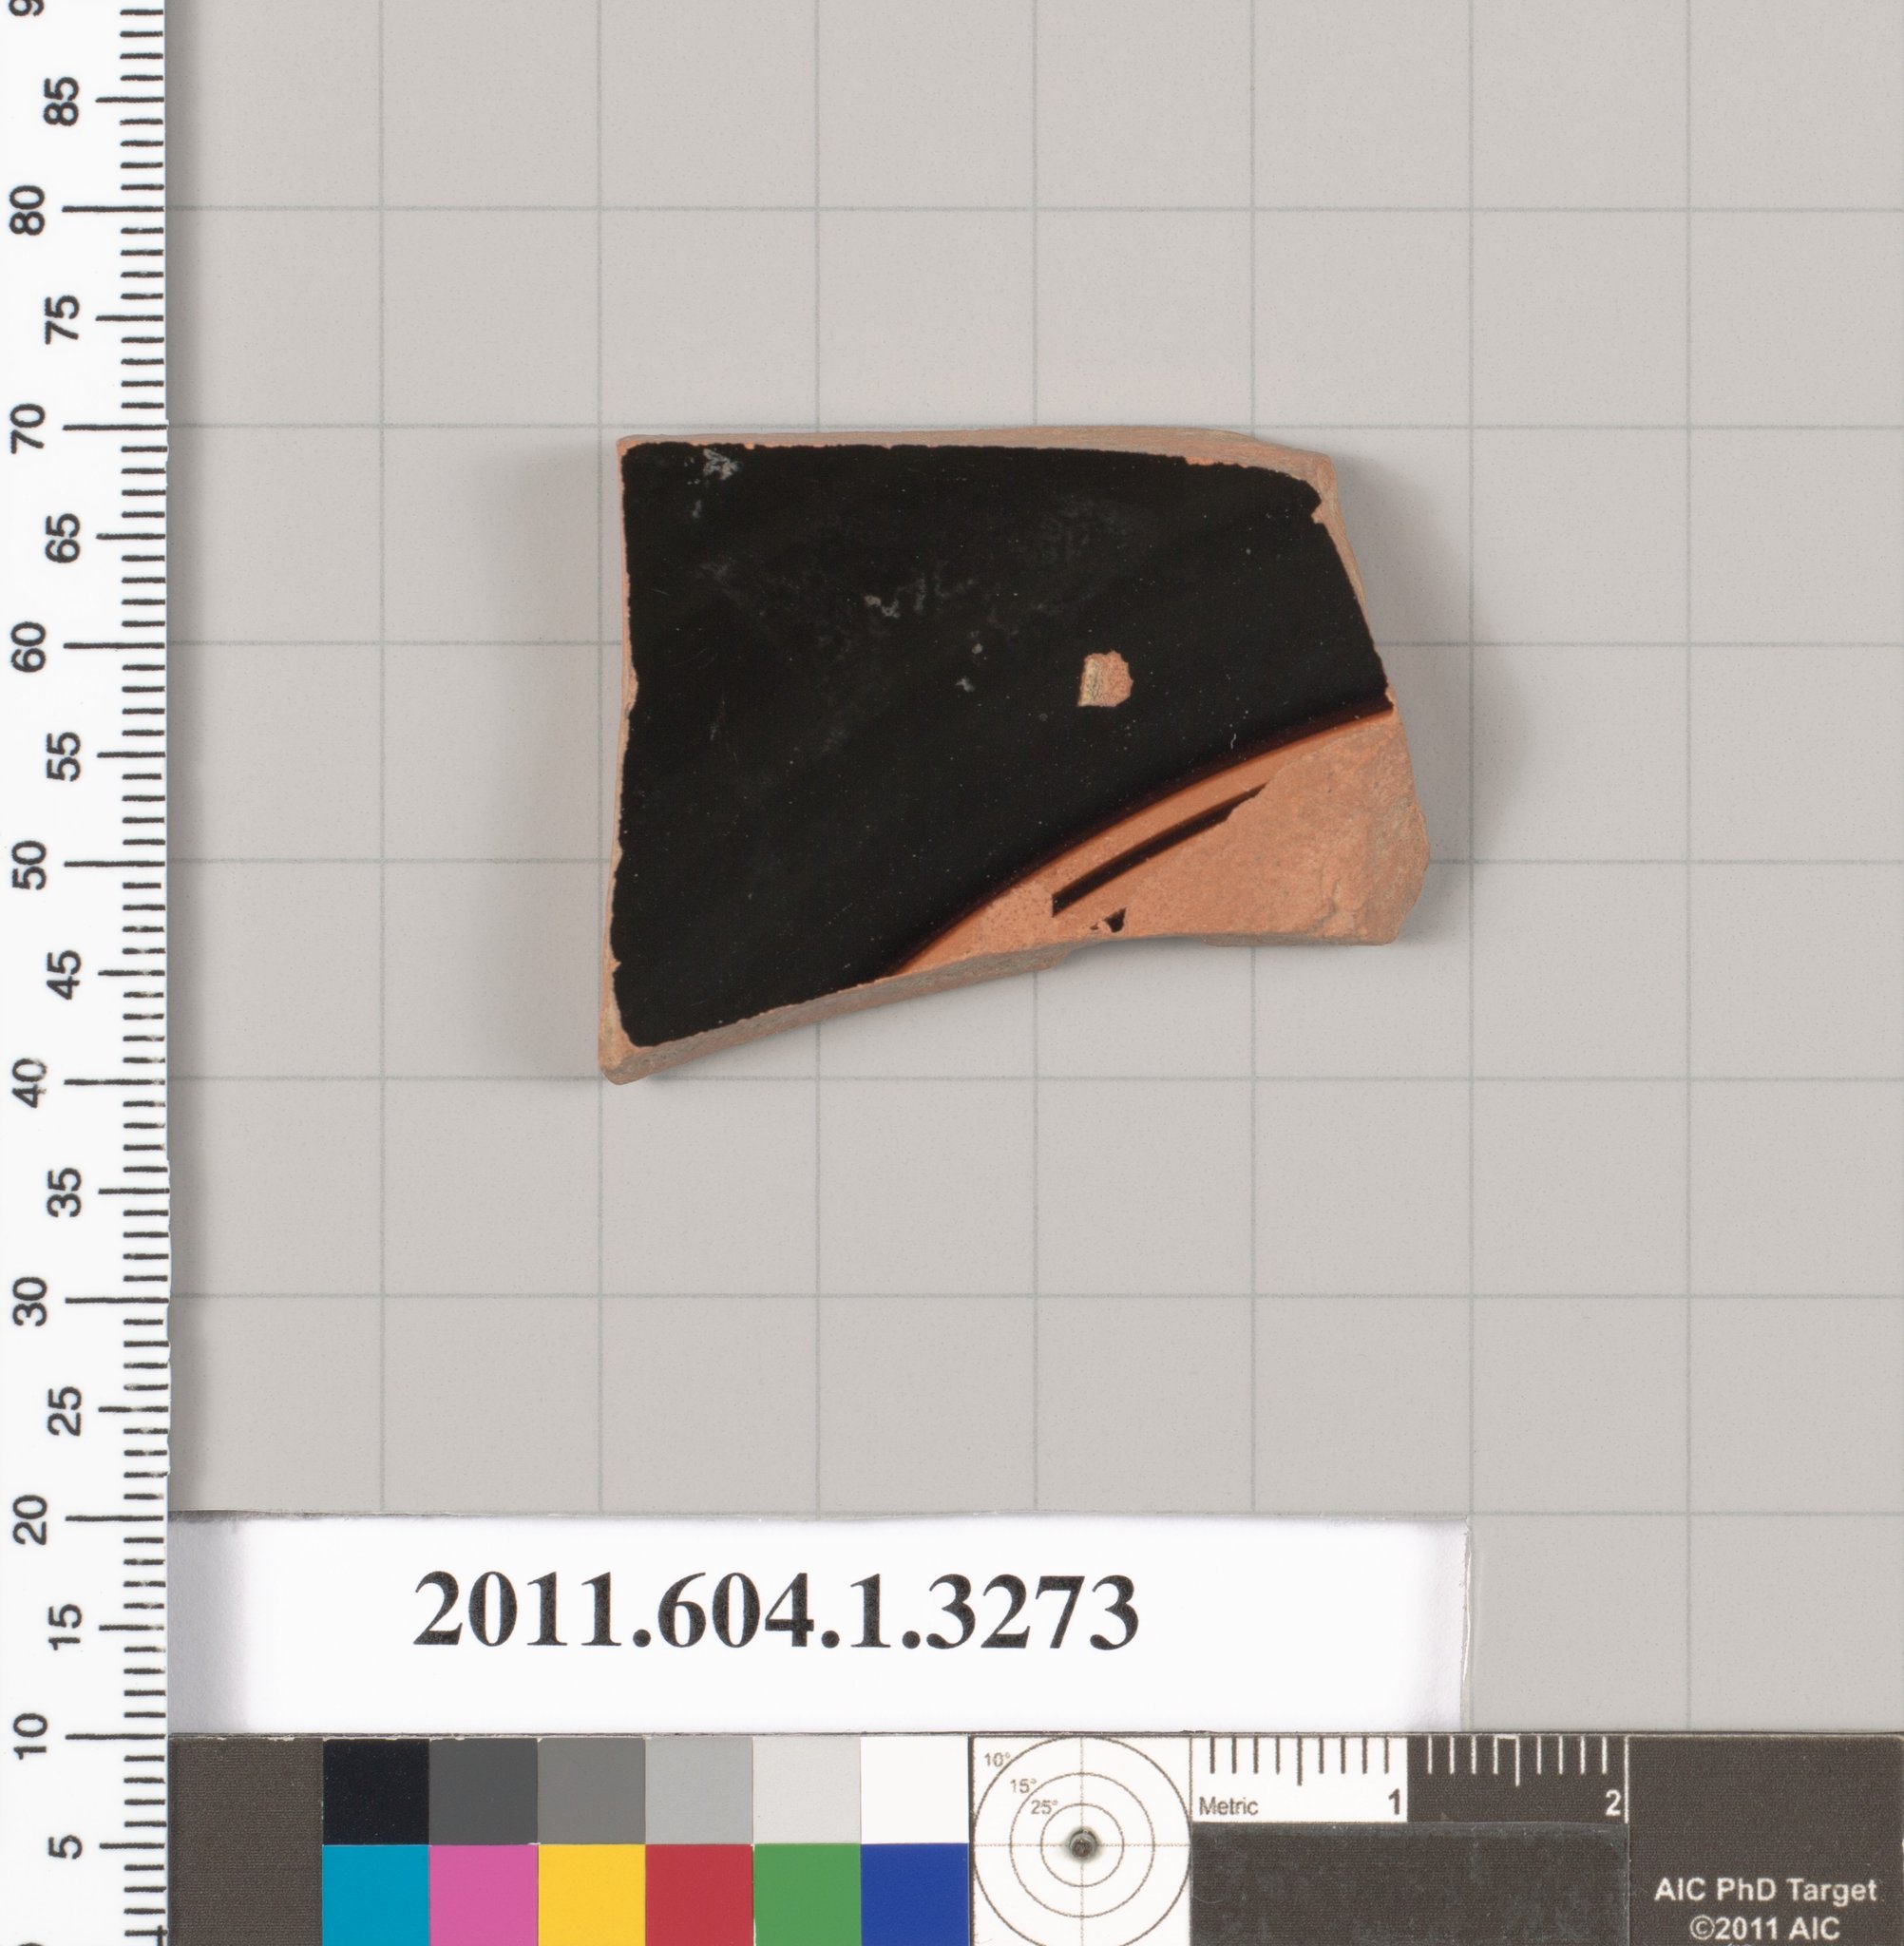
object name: kylix fragment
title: Terracotta fragment of a kylix (drinking cup)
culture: greek, attic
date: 500-490 BCE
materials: terracotta